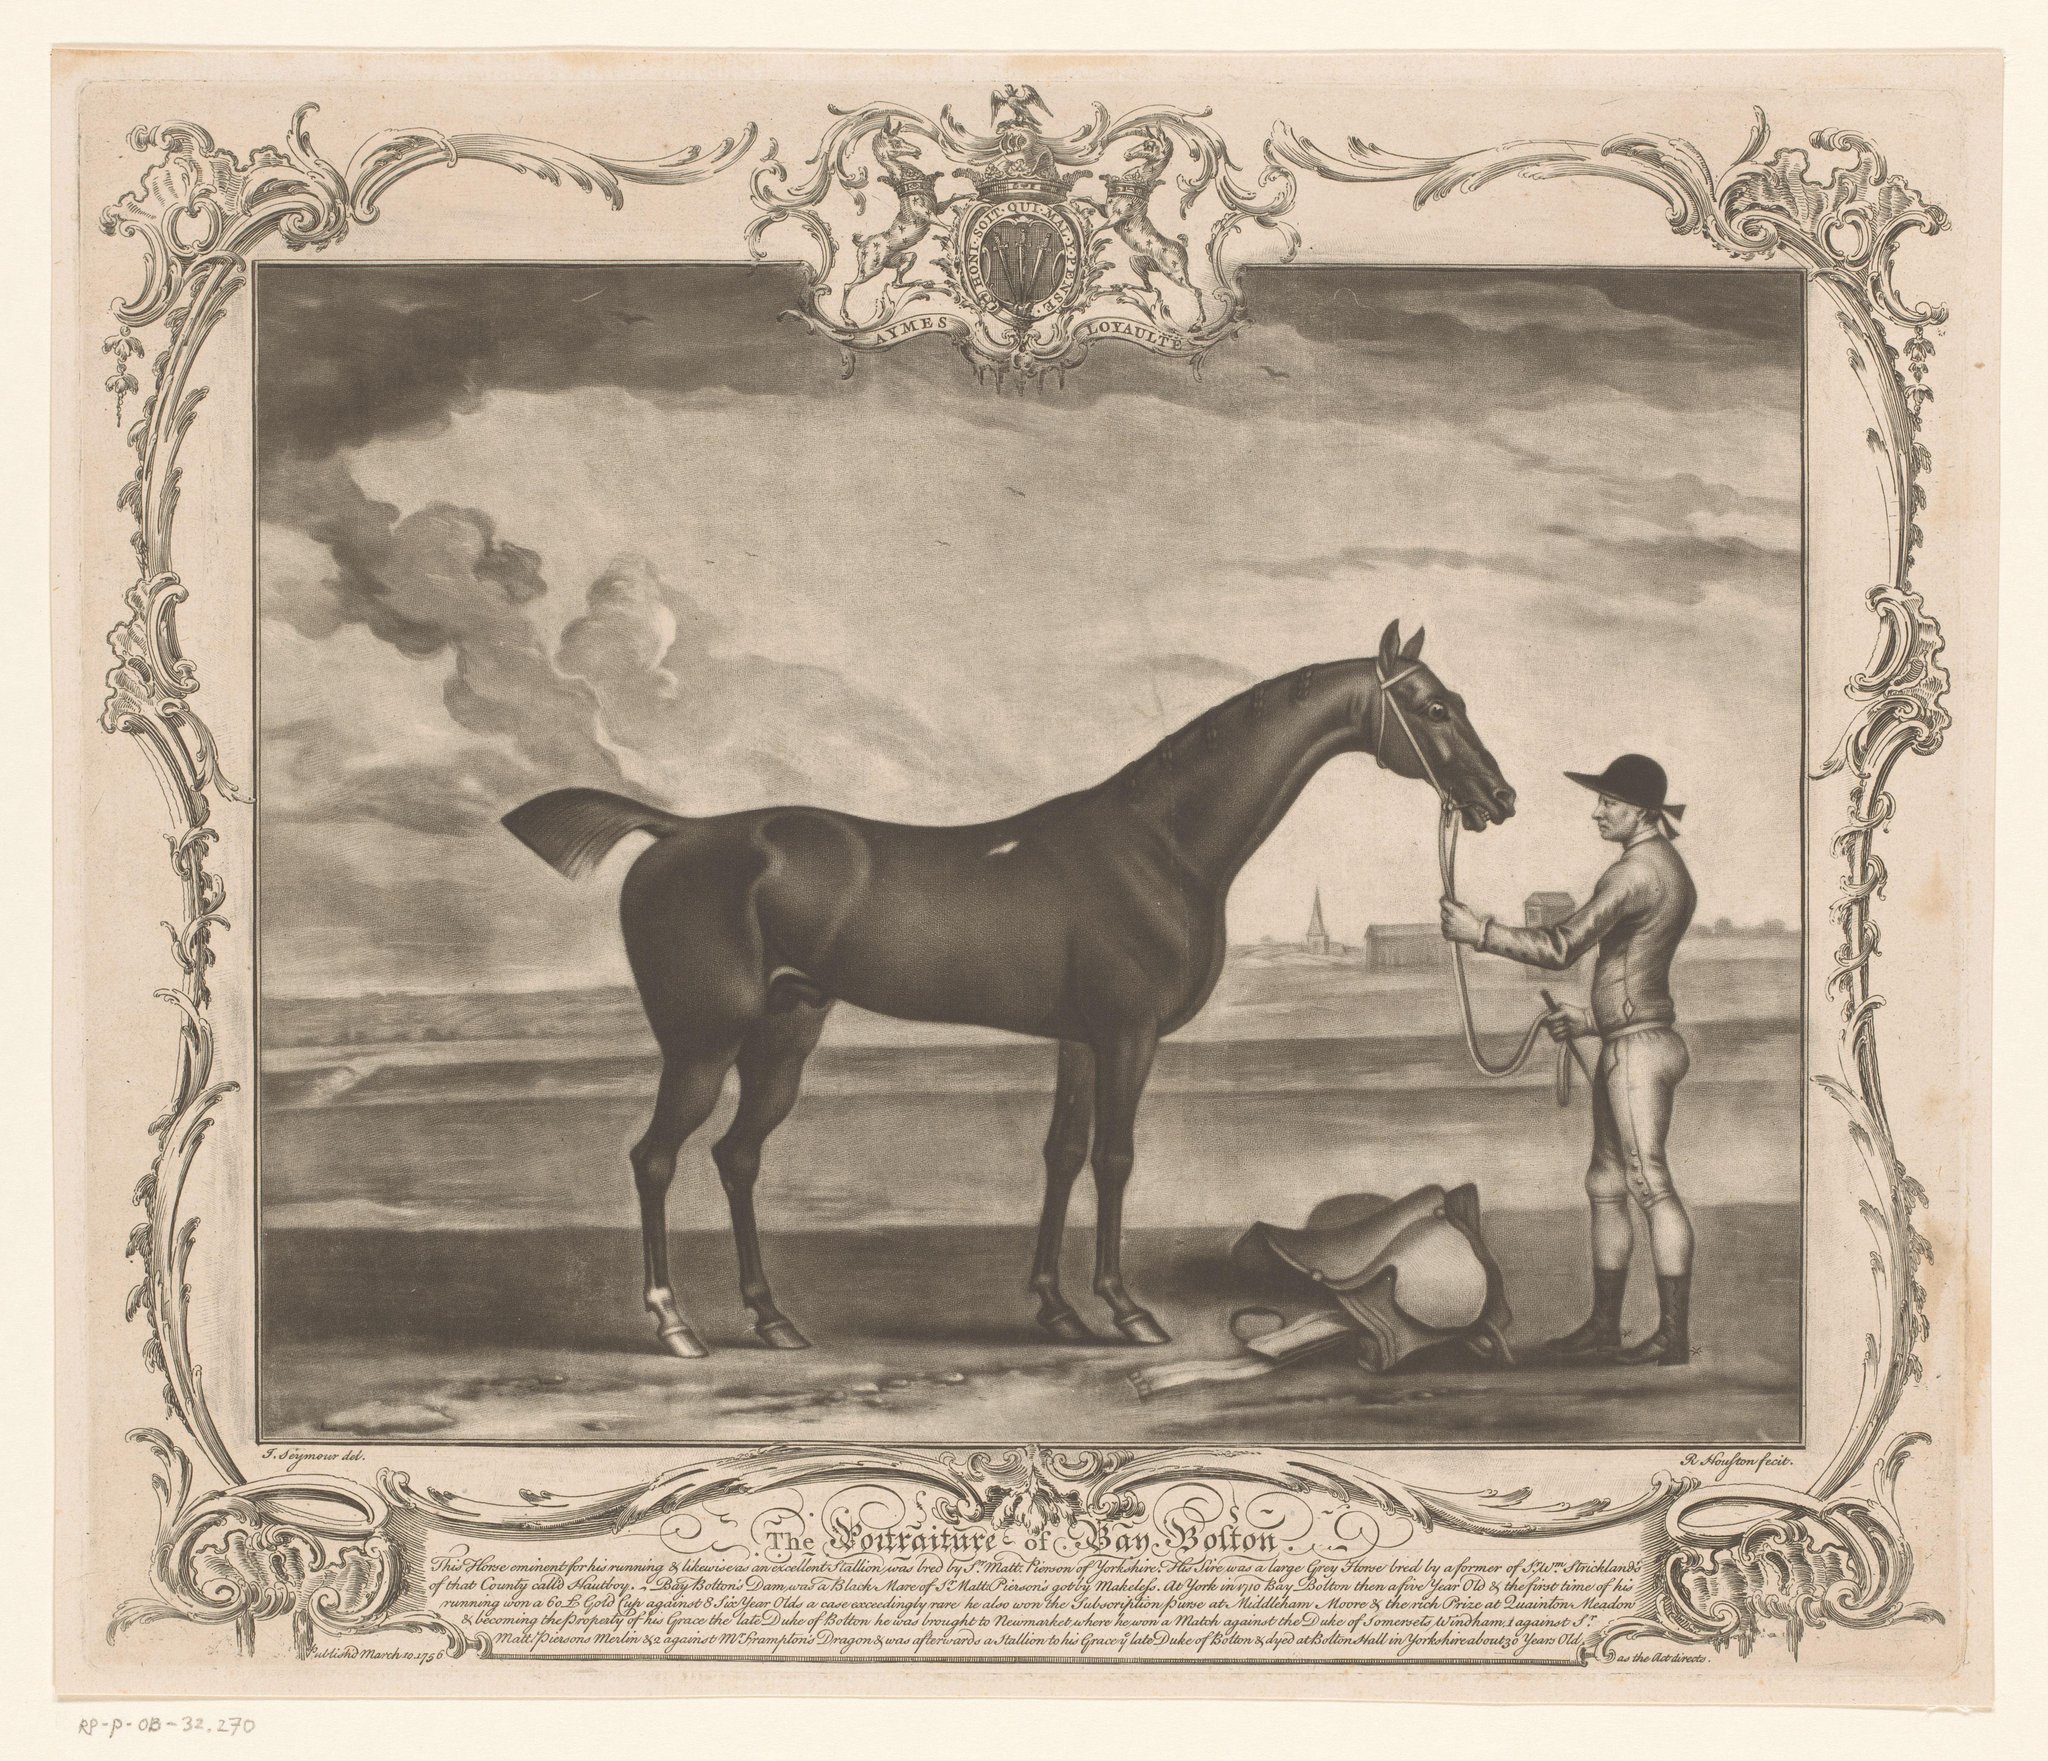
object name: print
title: The Portraiture of Ban Bolton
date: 1756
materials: paper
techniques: etching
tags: horse-racing, jockey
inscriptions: collector's mark: Lugt 2228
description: Tekst in het Engels in de ondermarge. De omkadering bevat een wapenschild met herten.